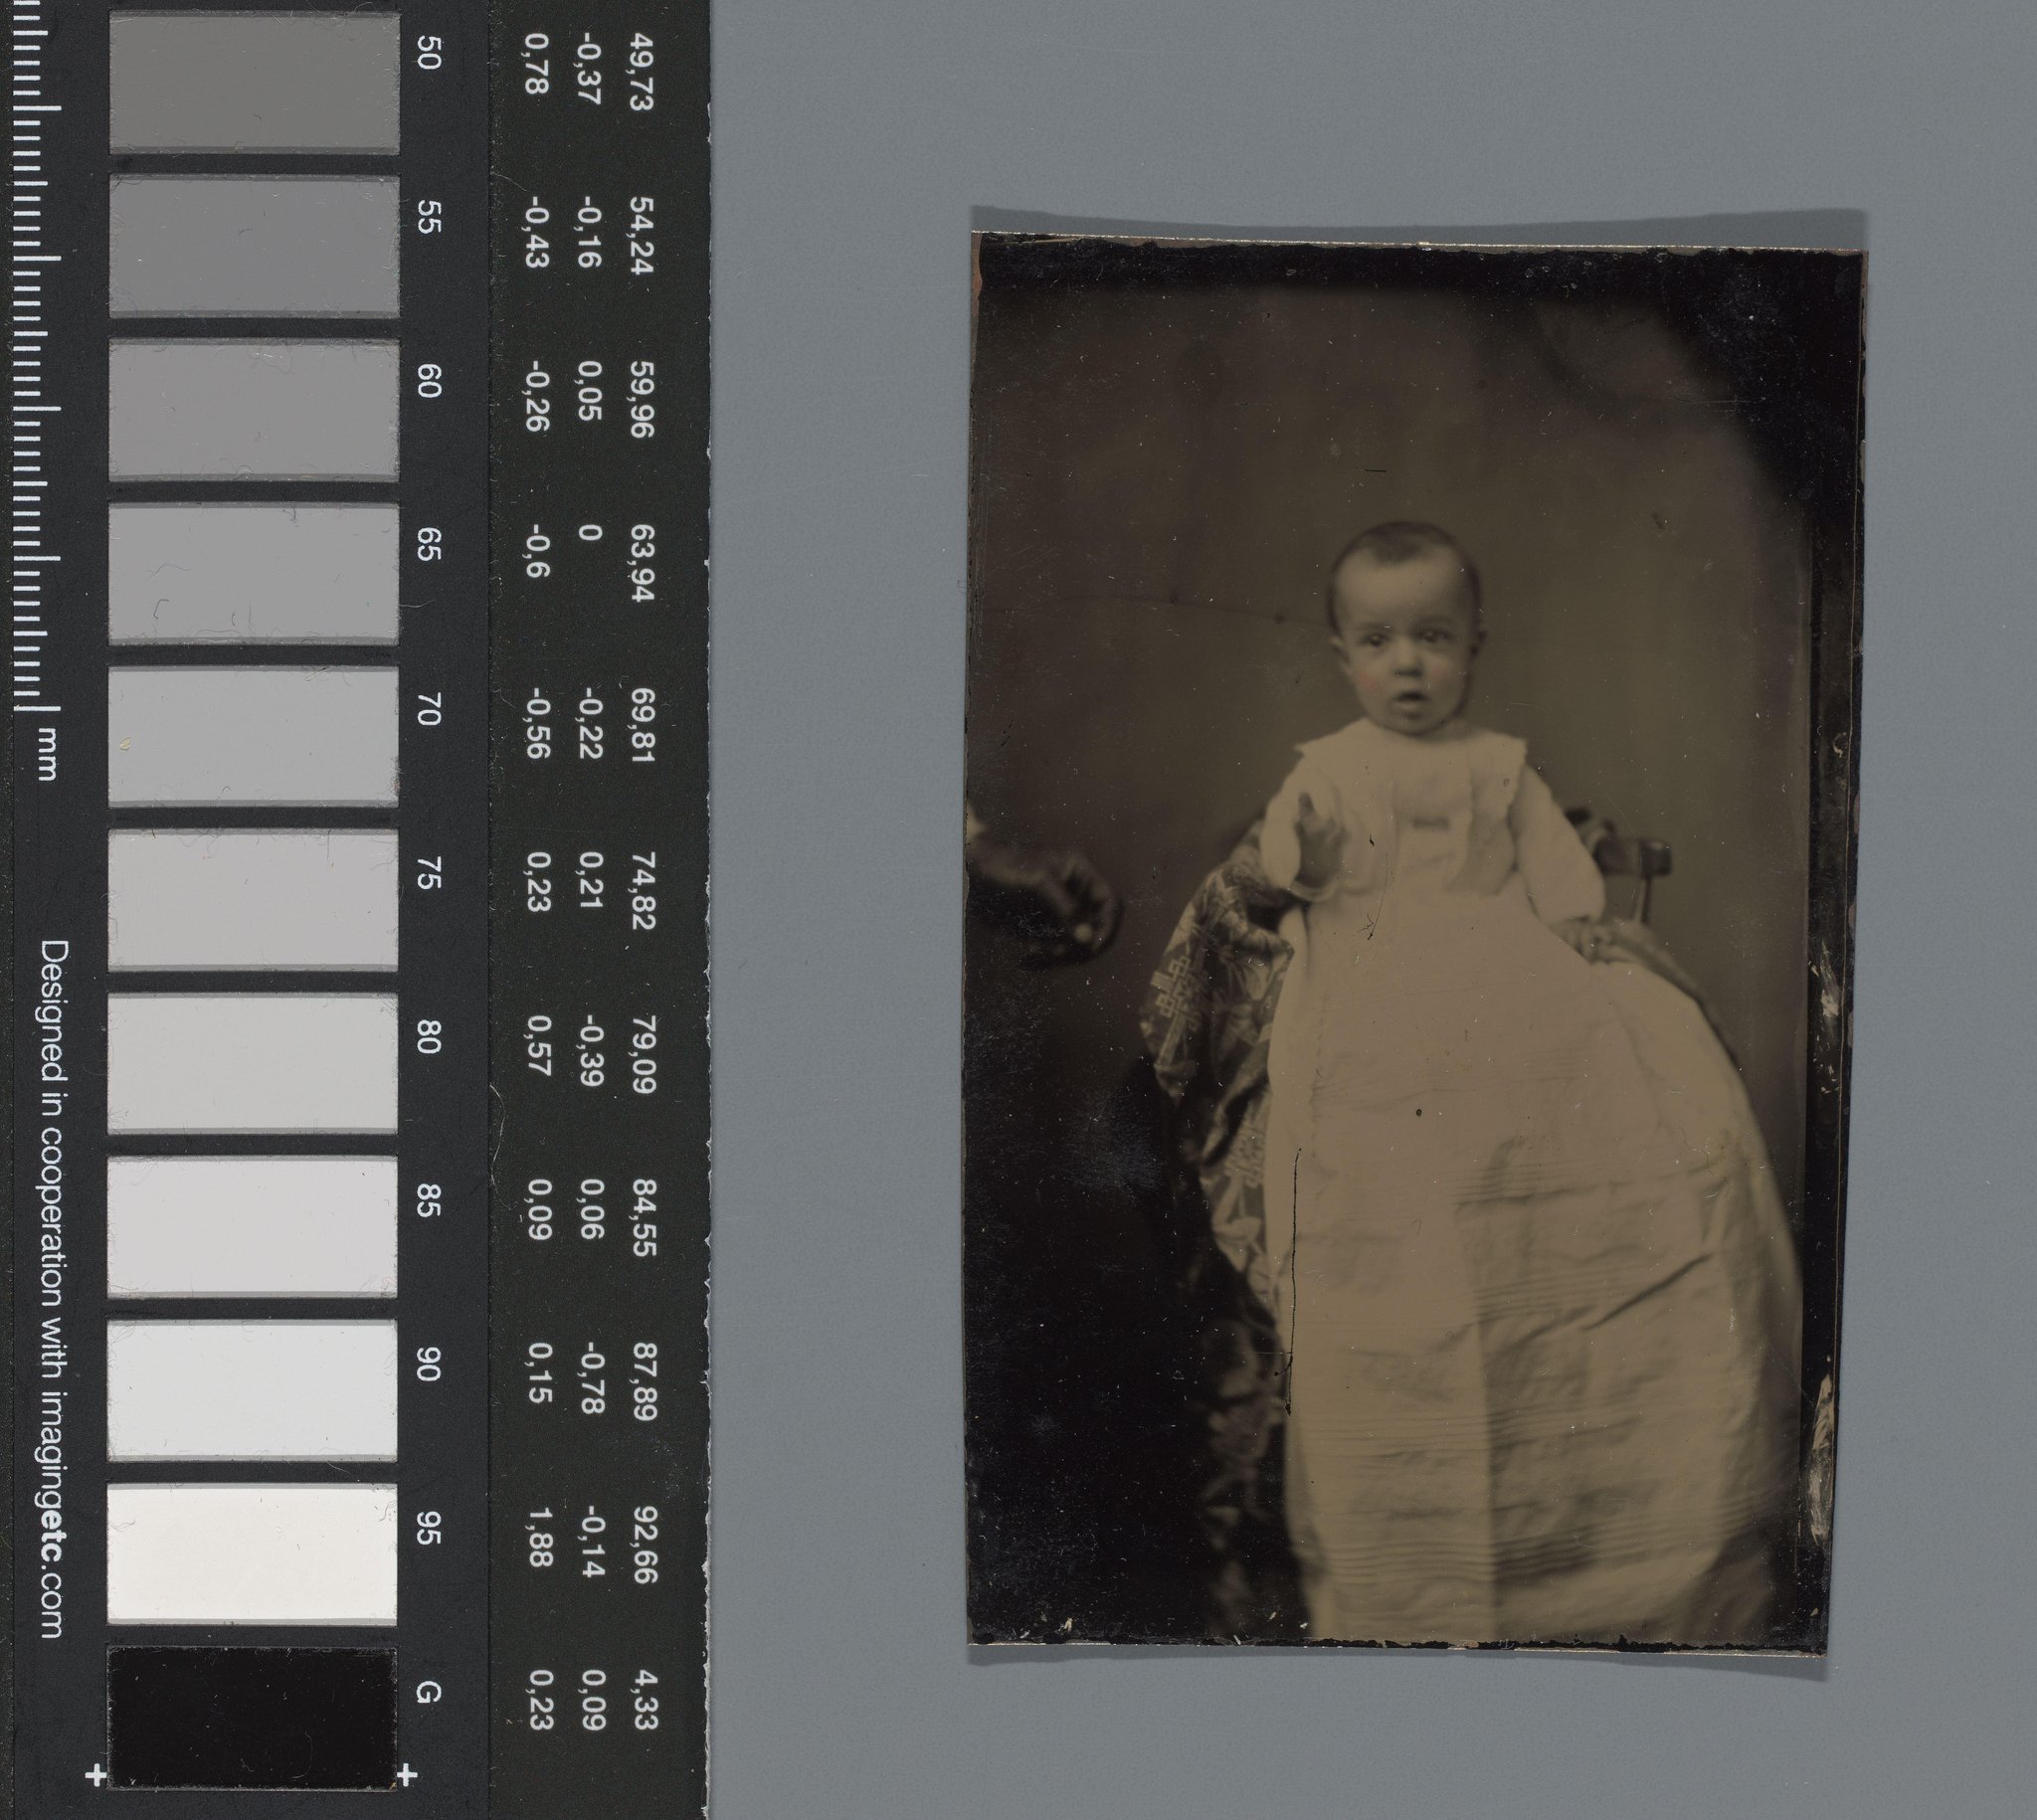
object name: photobook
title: Vrouw met baby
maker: Anonymous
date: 1870-1910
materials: photographic support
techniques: ferrotyping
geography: united states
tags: united states of america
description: Zittende witte baby, opzij een Zwarte hand.